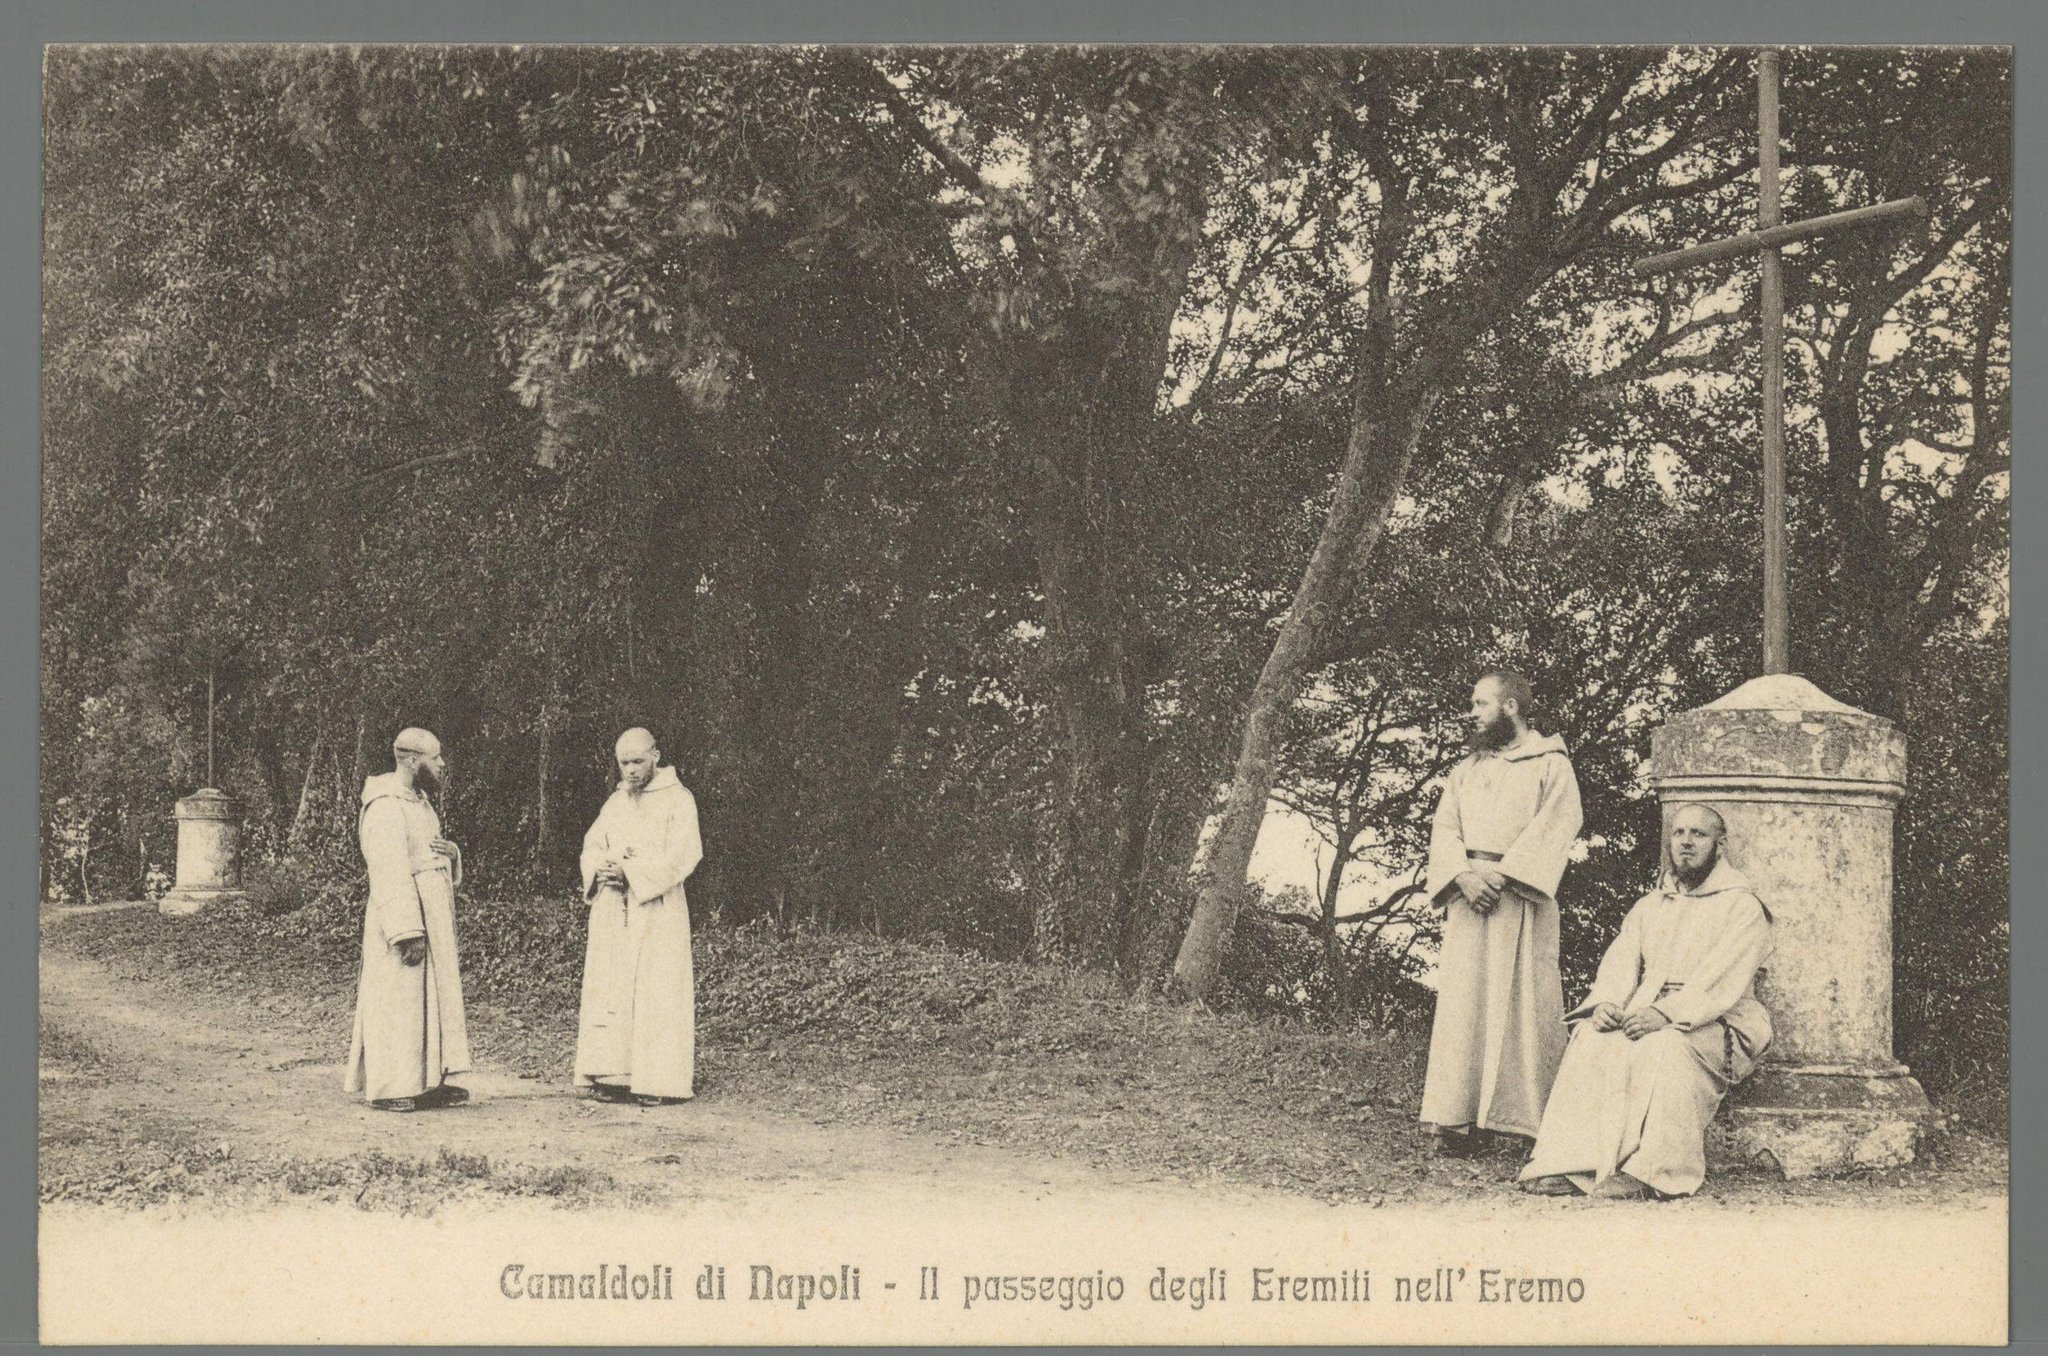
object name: ansichtkaart, prentbriefkaart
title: Camaldoli di Napoli. Il Passeggio degli Eremiti nell'Eremo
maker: Anonymous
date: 1906-1910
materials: cardboard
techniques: photograph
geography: terni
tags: garden, monk(s), friar(s), abbey garden, camaldoli